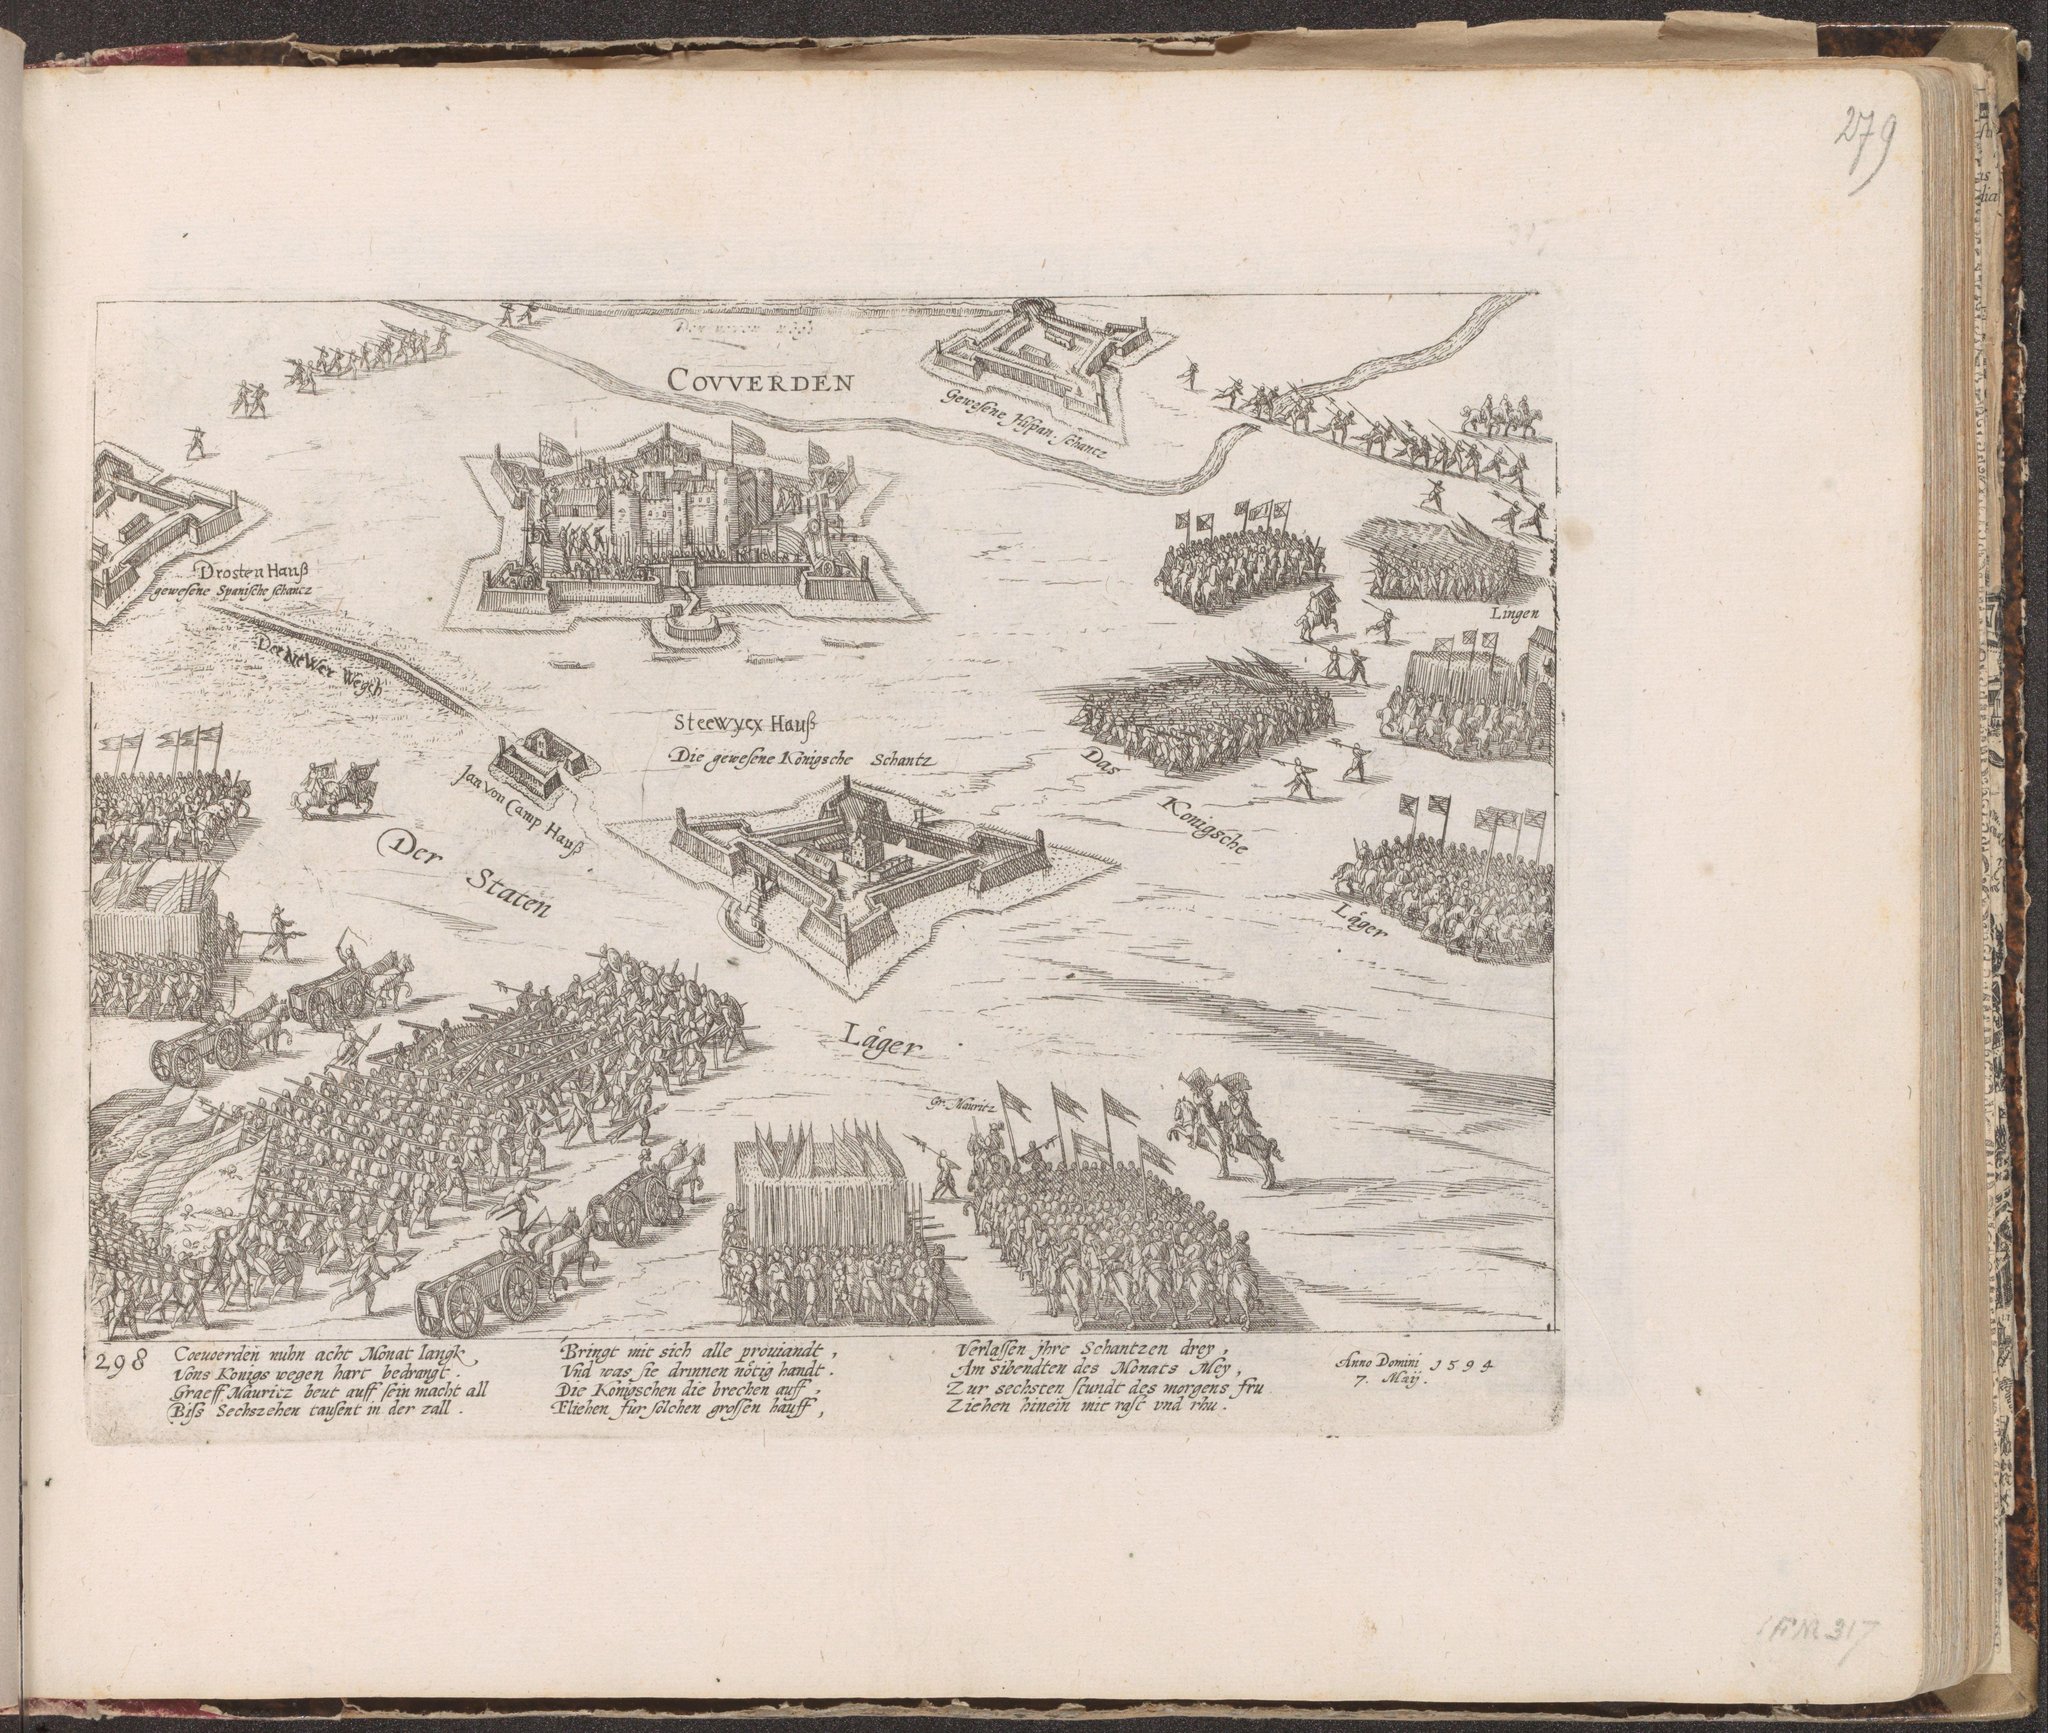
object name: album leaf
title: Ontzet van Coevorden, 1594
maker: frans hogenberg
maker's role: print maker, publisher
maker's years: 1538-1590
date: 1594-1596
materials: paper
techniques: etching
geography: cologne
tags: maurice (prince of orange), raising the siege with outside assistance, relief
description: Ontzet van Coevorden, 7 mei 1594. Aftocht van het Spaanse leger onder Verdugo dat Coevorden belegerde als het Staatse leger onder prins Maurits aankomt bij de stad. Met onderschrift van 12 regels in het Duits. Linksonder genummerd: 298. De prent maakt deel uit van een album.